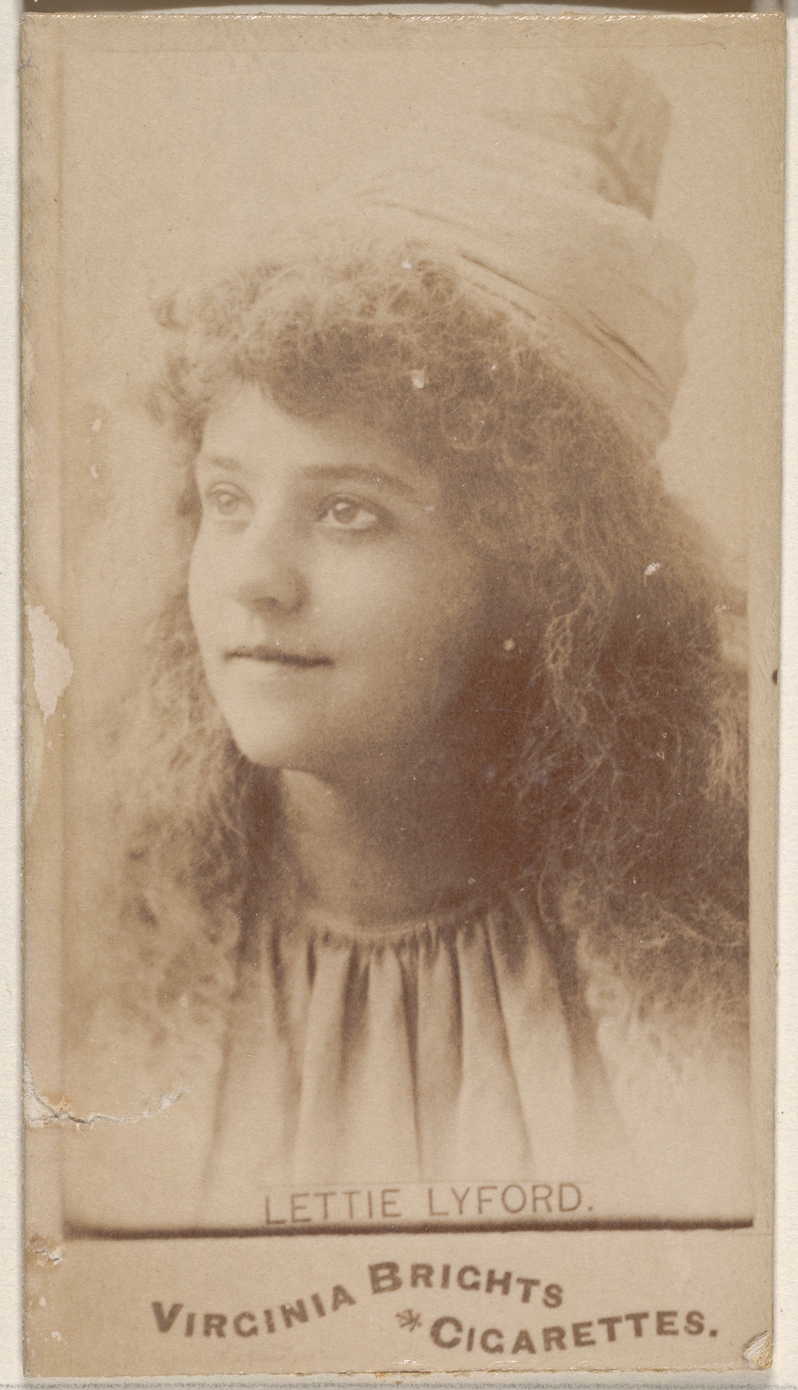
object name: photograph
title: Lettie Lyford, from the Actors and Actresses series (N45, Type 1) for Virginia Brights Cigarettes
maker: allen & ginter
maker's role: publisher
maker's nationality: american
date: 1888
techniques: albumen silver print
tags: portraits,women,actresses